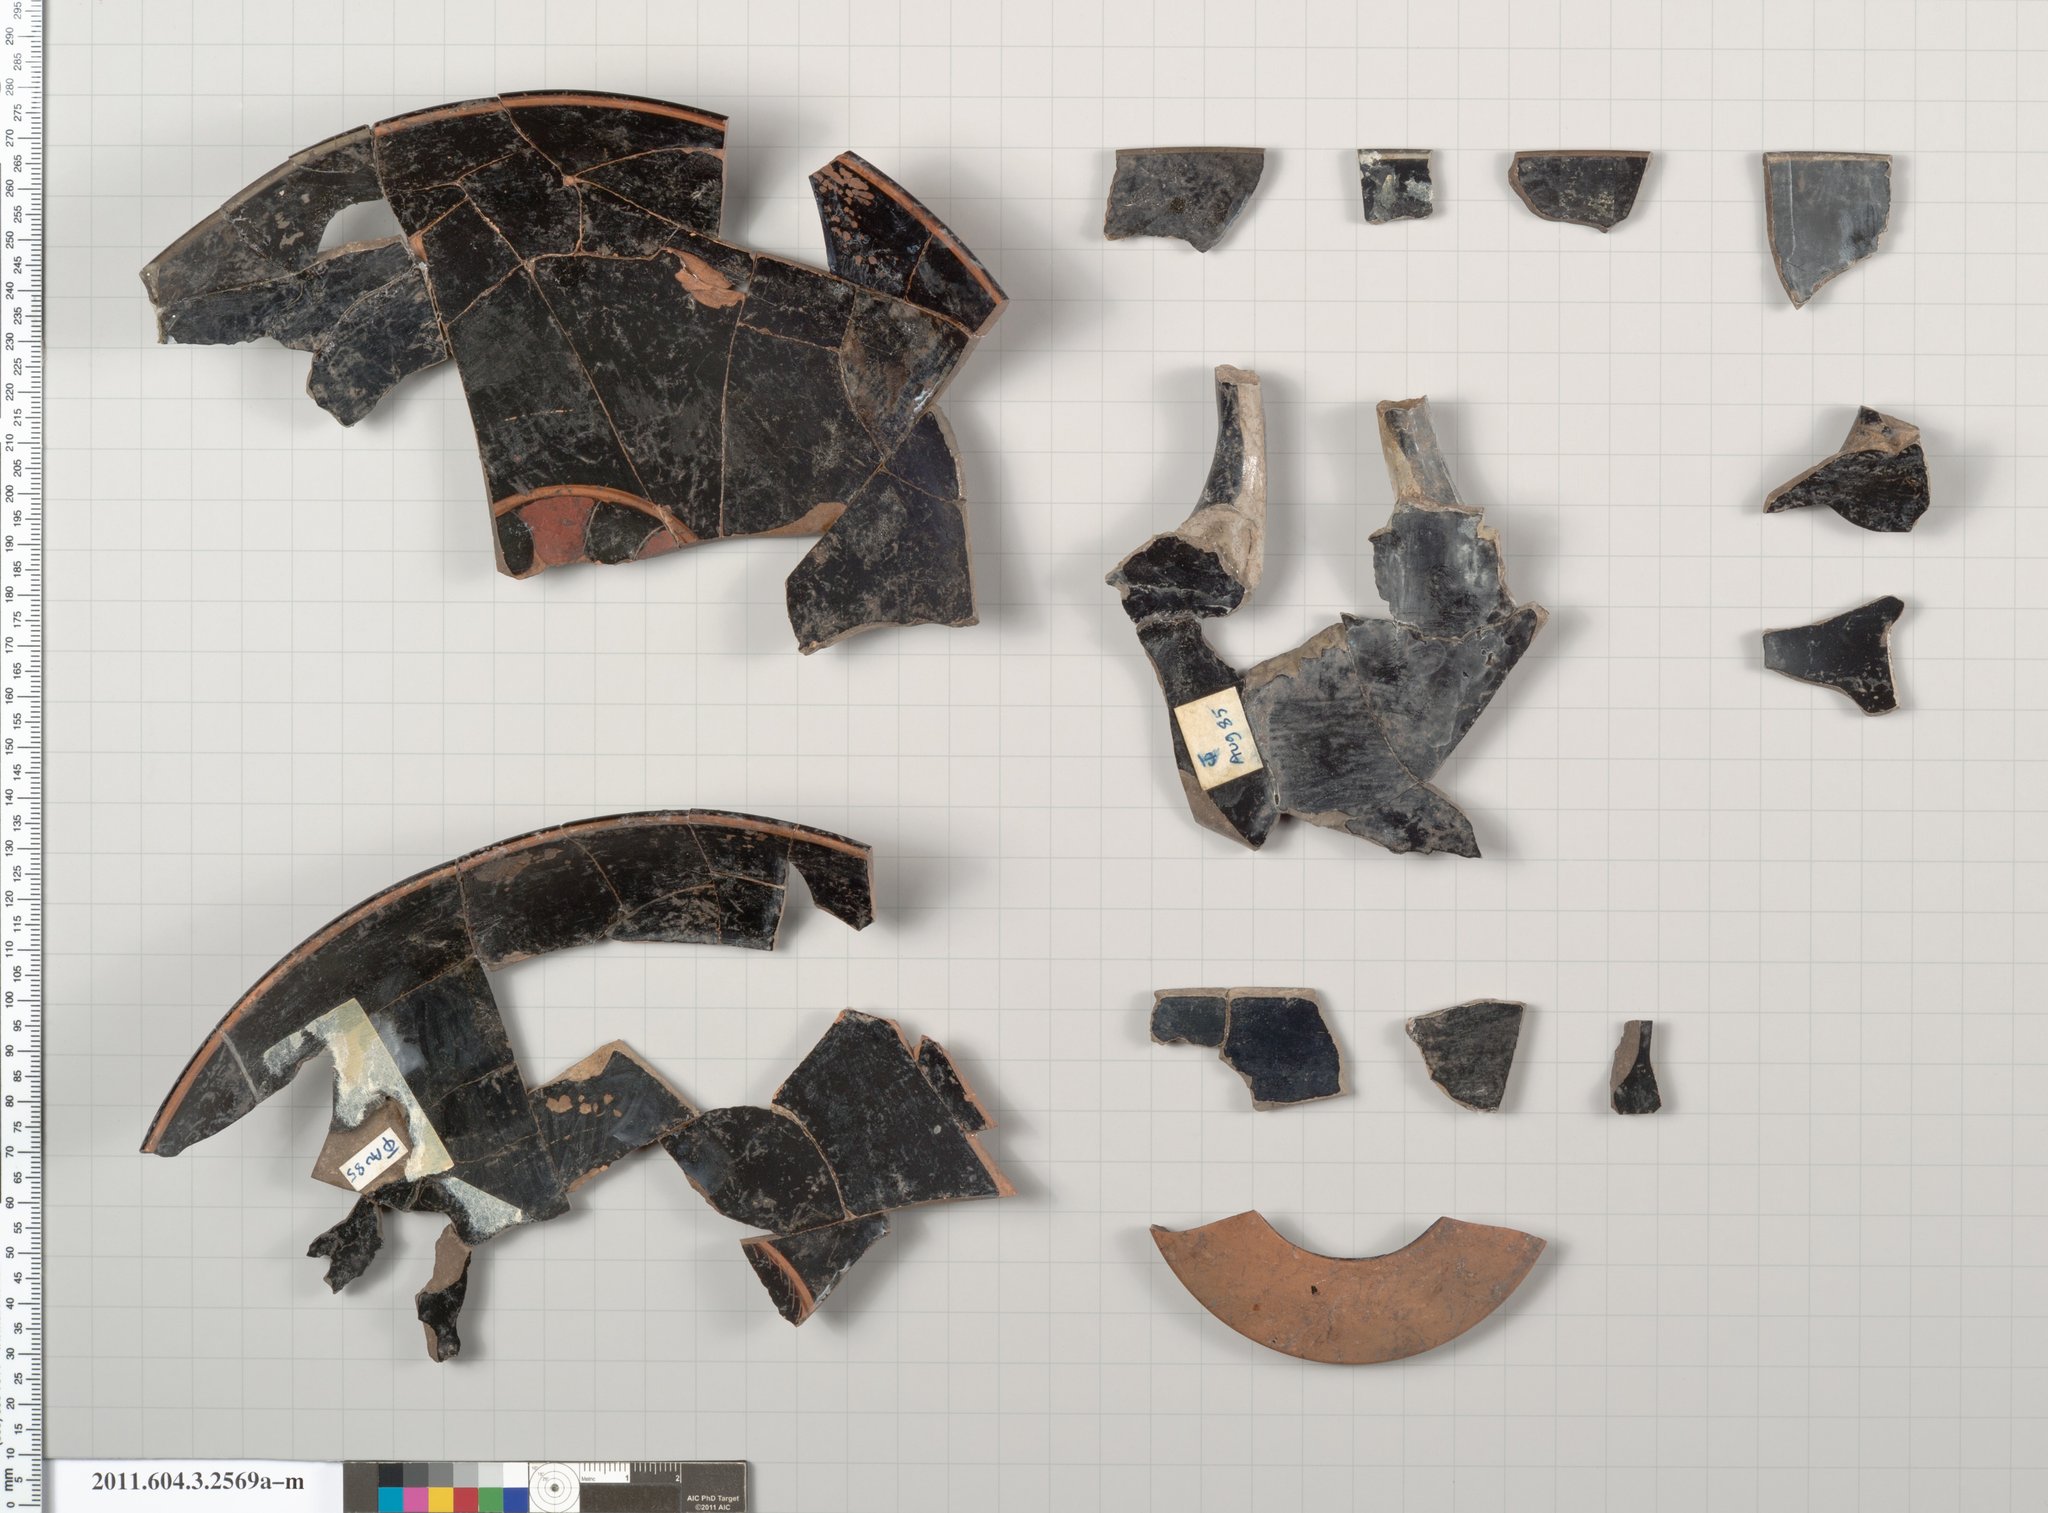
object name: kylix fragment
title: Terracotta fragments of a kylix: eye-cup (drinking cup)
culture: greek, attic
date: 530-520 BCE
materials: terracotta